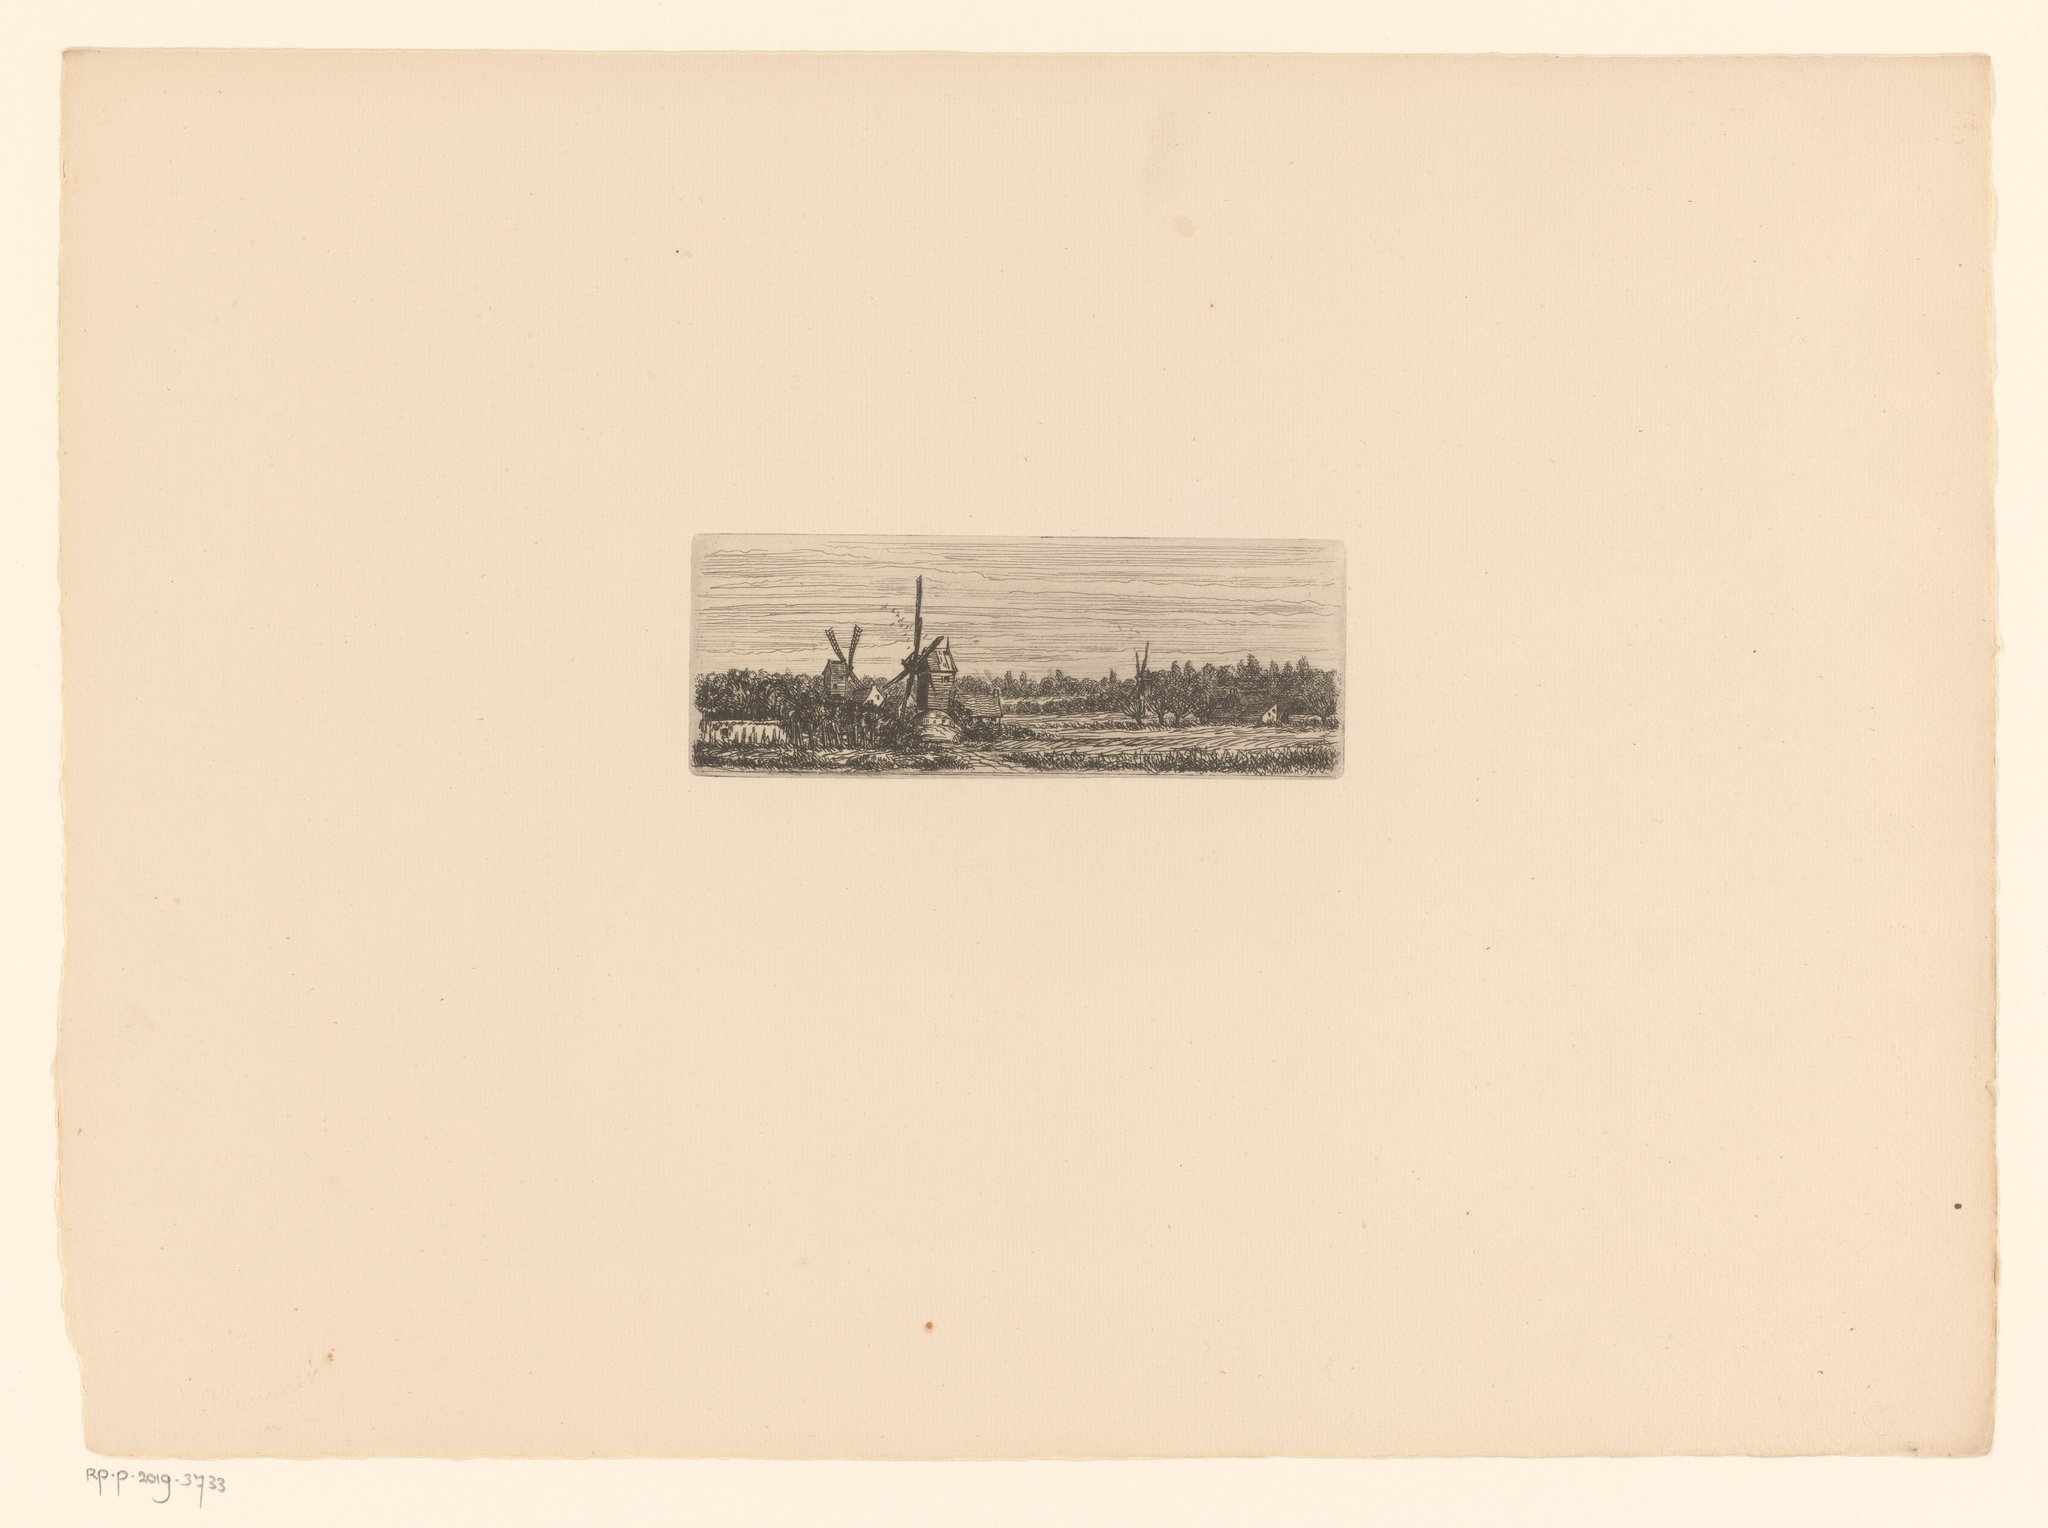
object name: print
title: Landschap met drie molens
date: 1875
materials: paper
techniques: drypoint, etching, intaglio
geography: brussels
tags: windmill in landscape, windmill